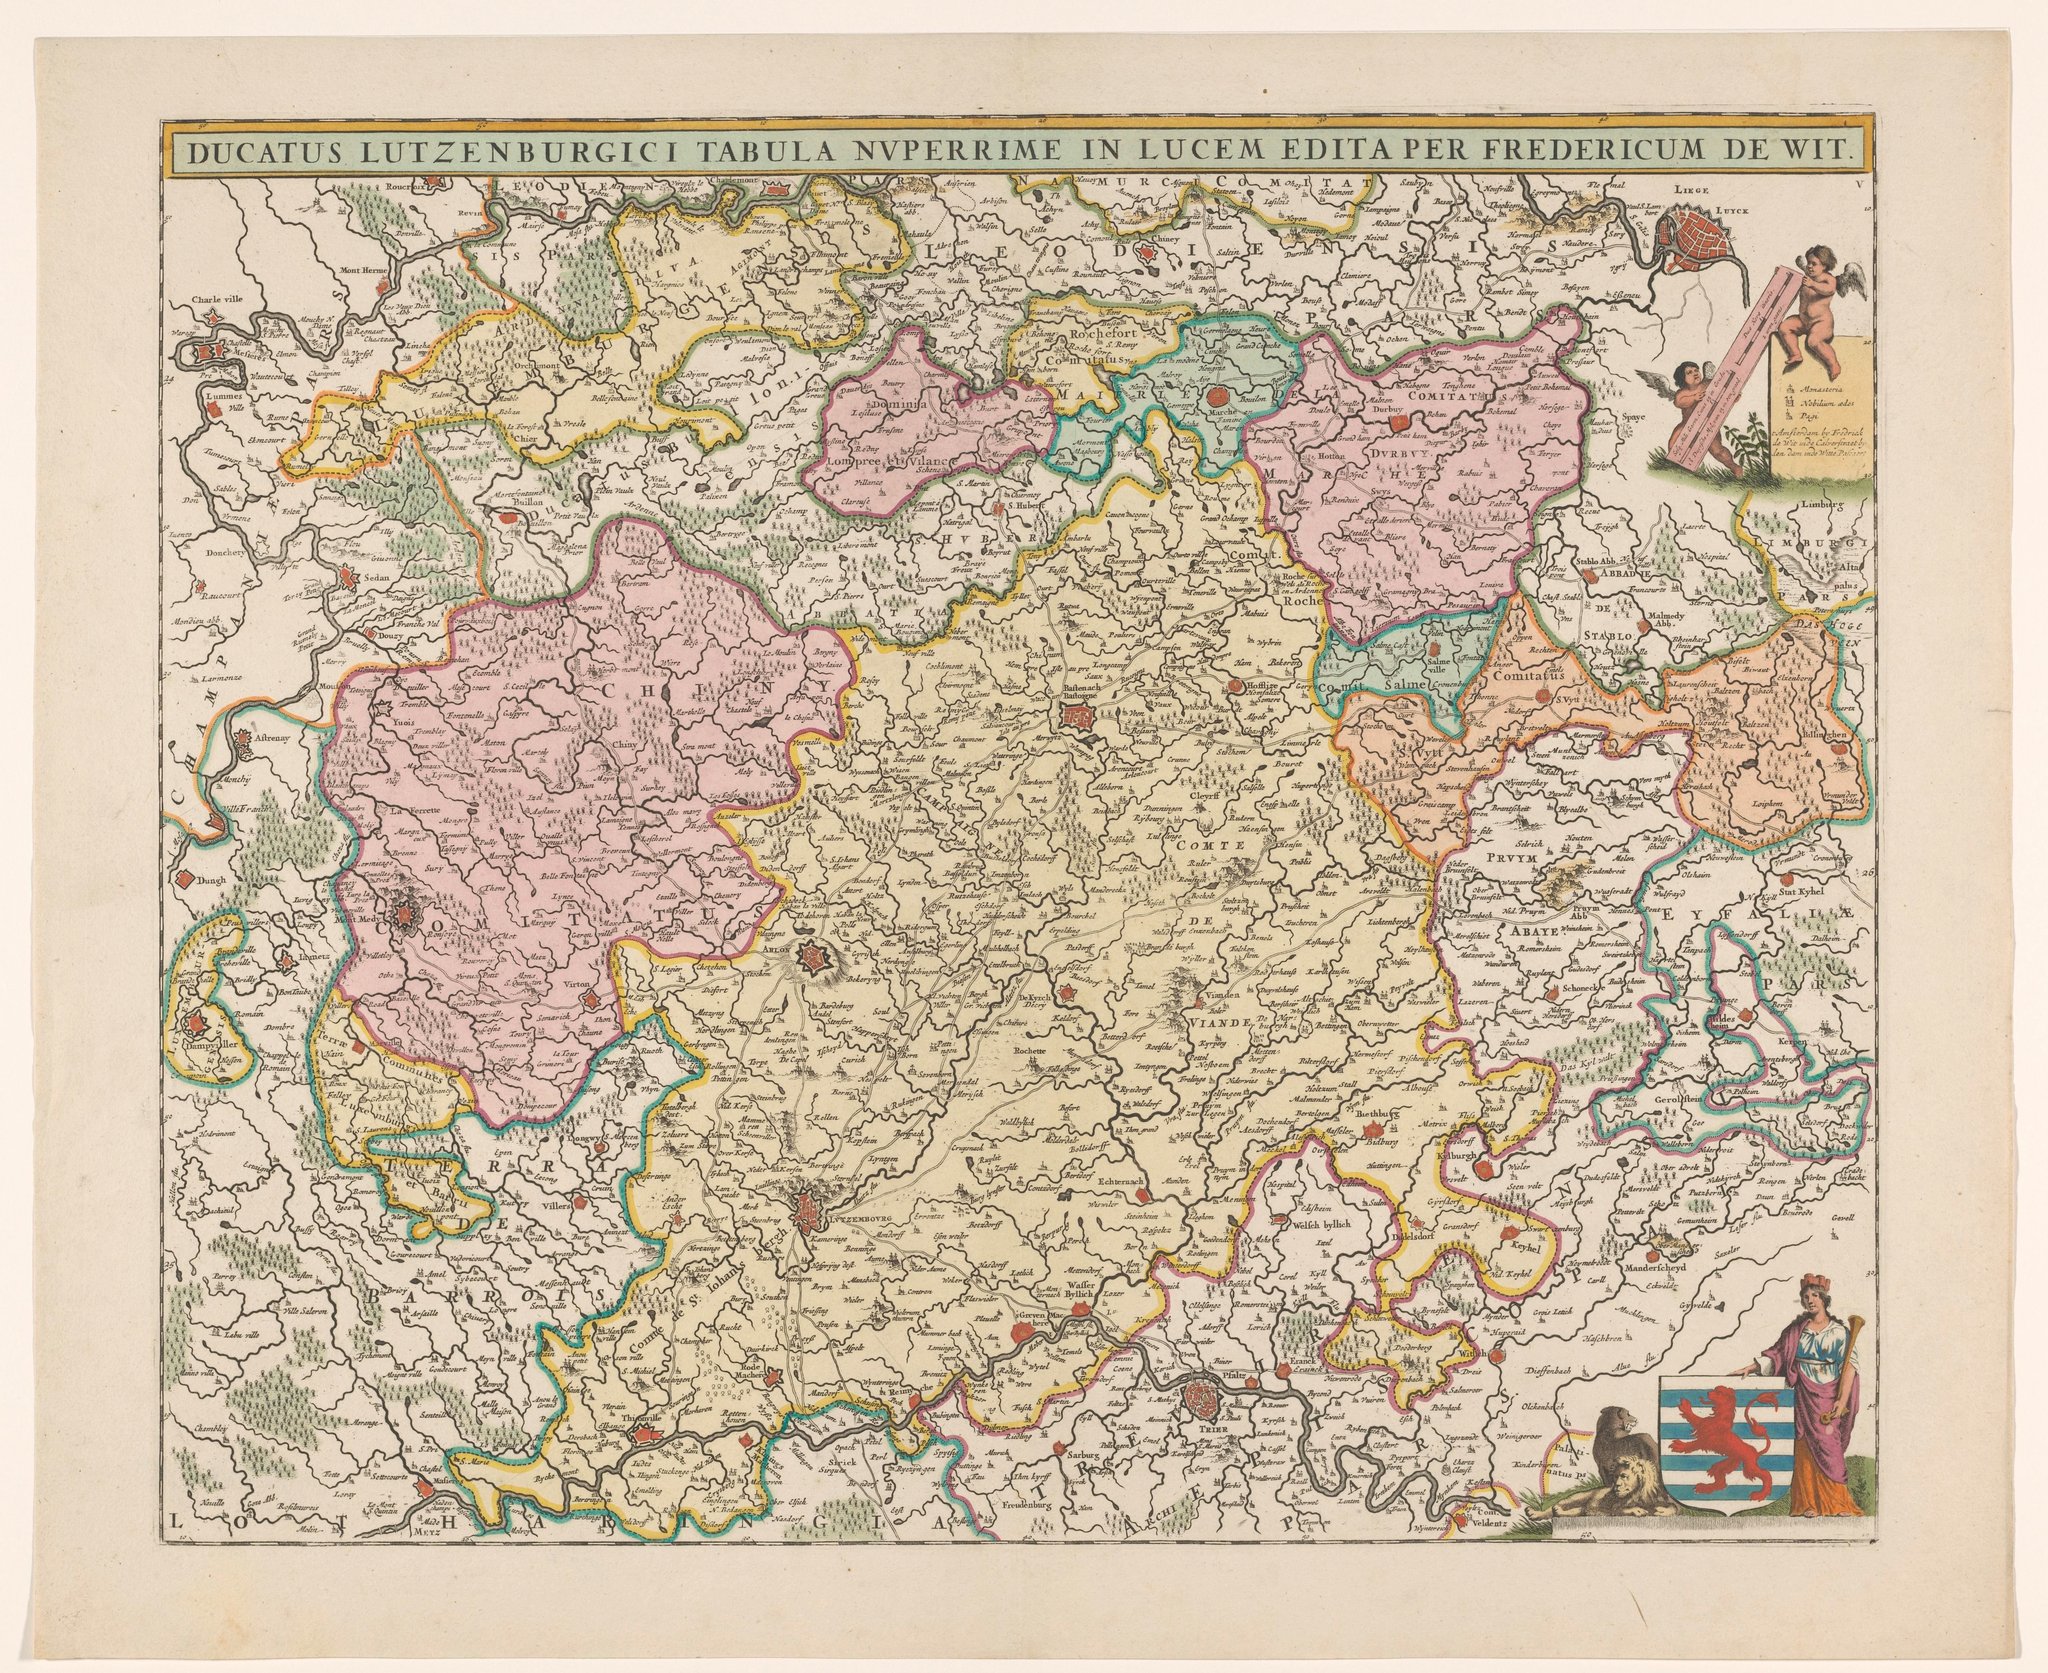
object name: print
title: Kaart van het hertogdom Luxemburg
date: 1689-1707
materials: paper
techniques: engraving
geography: amsterdam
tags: maps of separate countries or regions, coat of arms (as symbol of the state, etc.) (+ province; provincial)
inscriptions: collector's mark: Lugt 2228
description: Kaart van het hertogdom Luxemburg. In een balk boven de kaart de titel. Rechtsonder het wapen van het hertogdom Luxemburg. Rechtsboven een cartouche met legenda en twee putti met een balk met daarop twee schaalstokken: 1 1/2 Duytsche Myl van 15 in een graed / 2 uren gaens. De kaart is voorzien van een gradenverdeling langs de randen. Rechtsboven gemerkt: V.